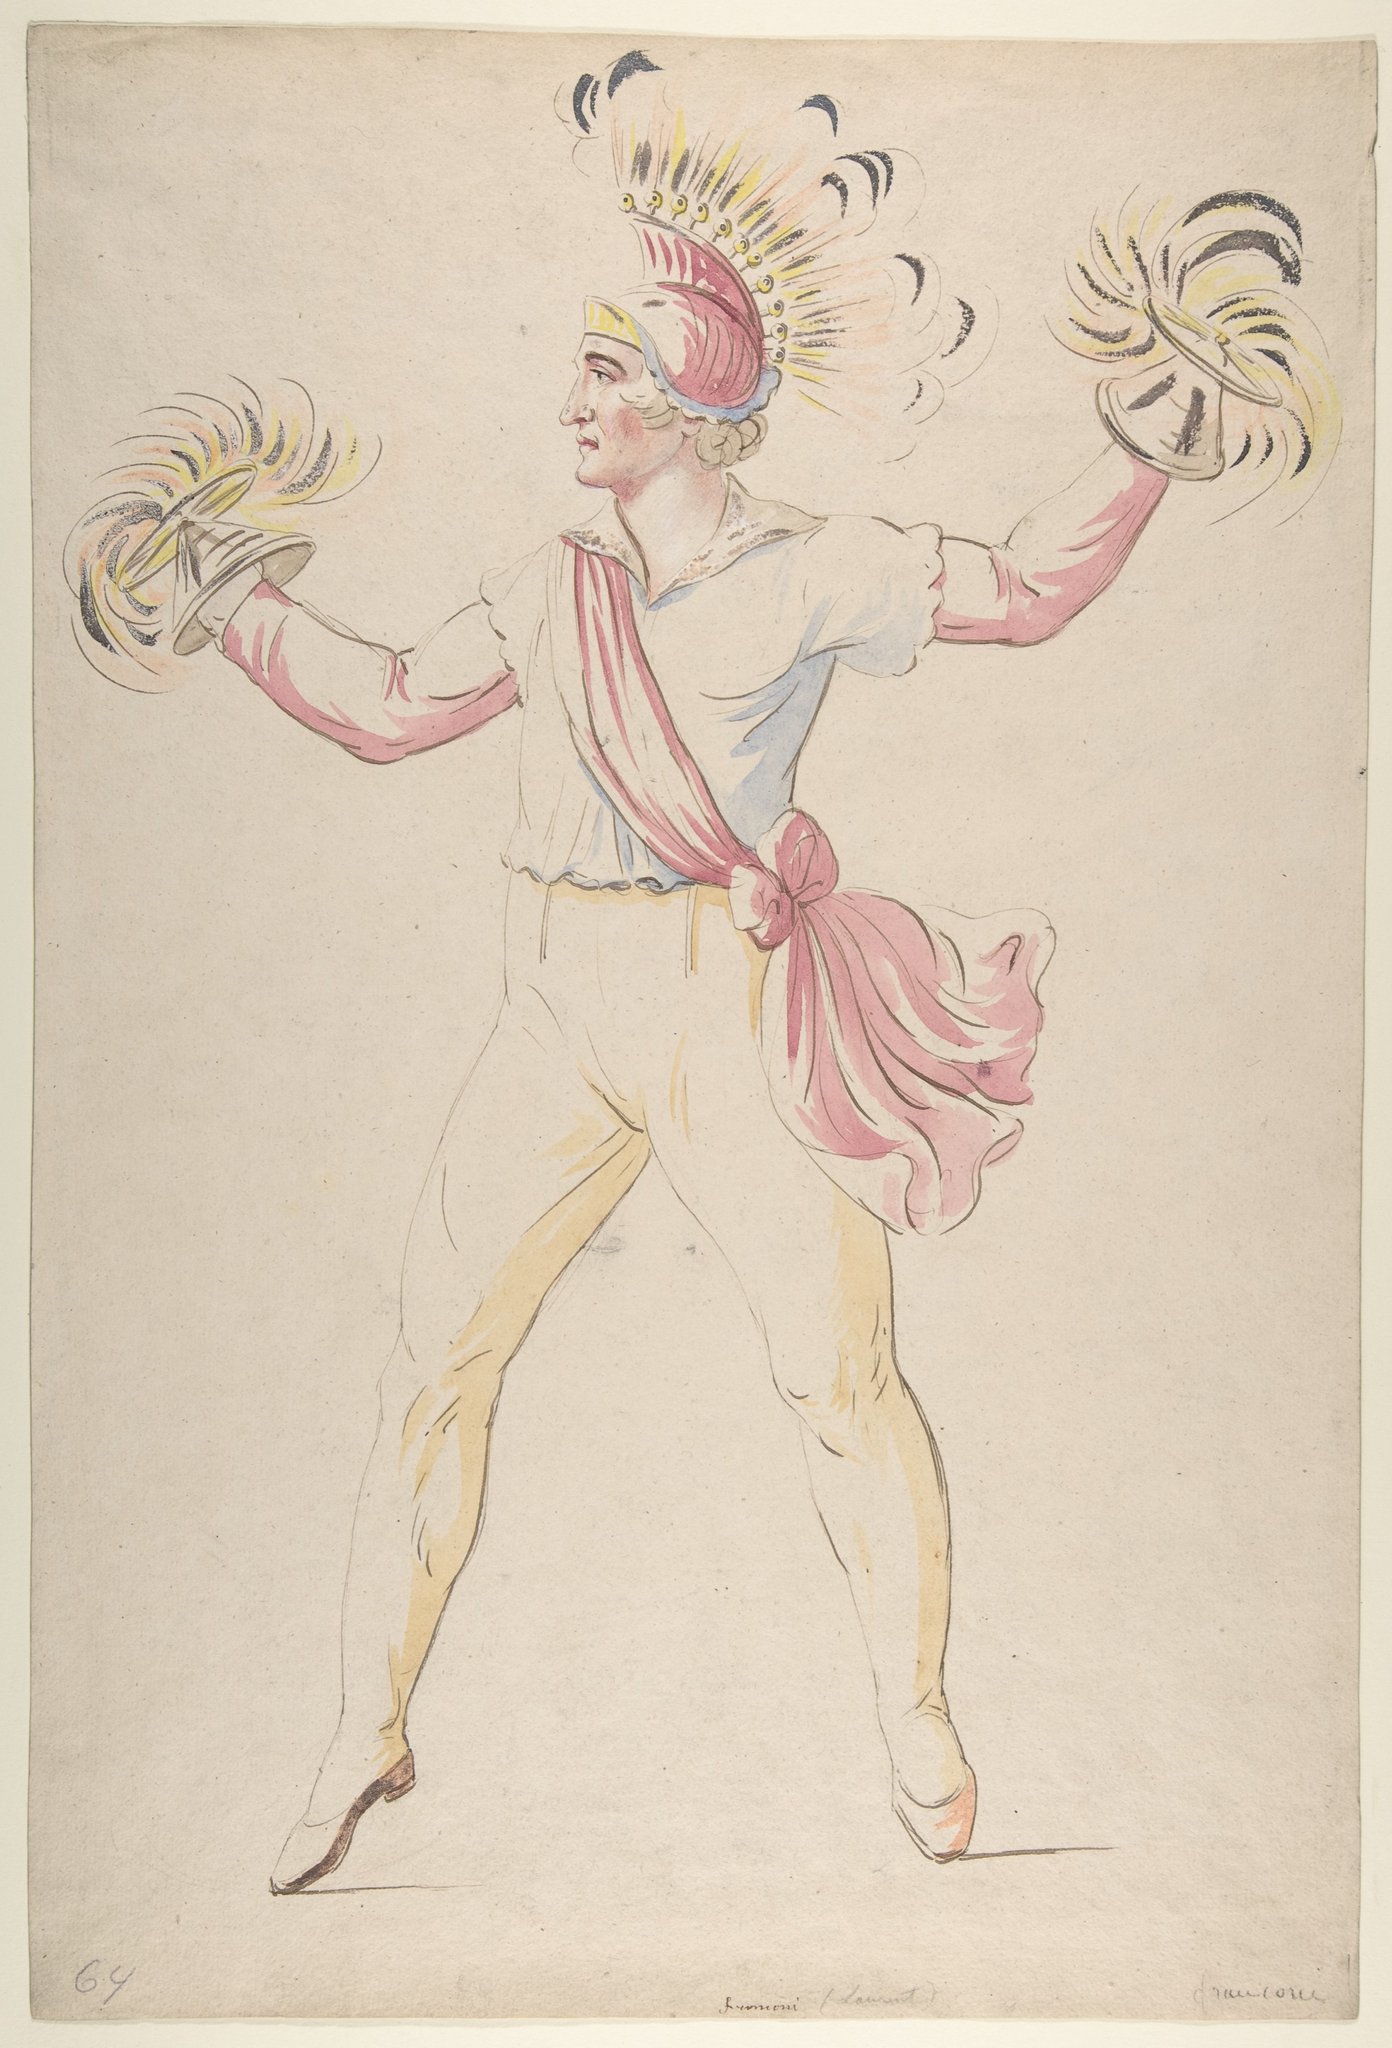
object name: drawing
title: Franconi, Twirling Flaming Cones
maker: abraham louis rodolphe ducros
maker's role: artist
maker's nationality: swiss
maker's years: 1748-1810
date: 1768-1810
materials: gouache, ink, watercolor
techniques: pen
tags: men